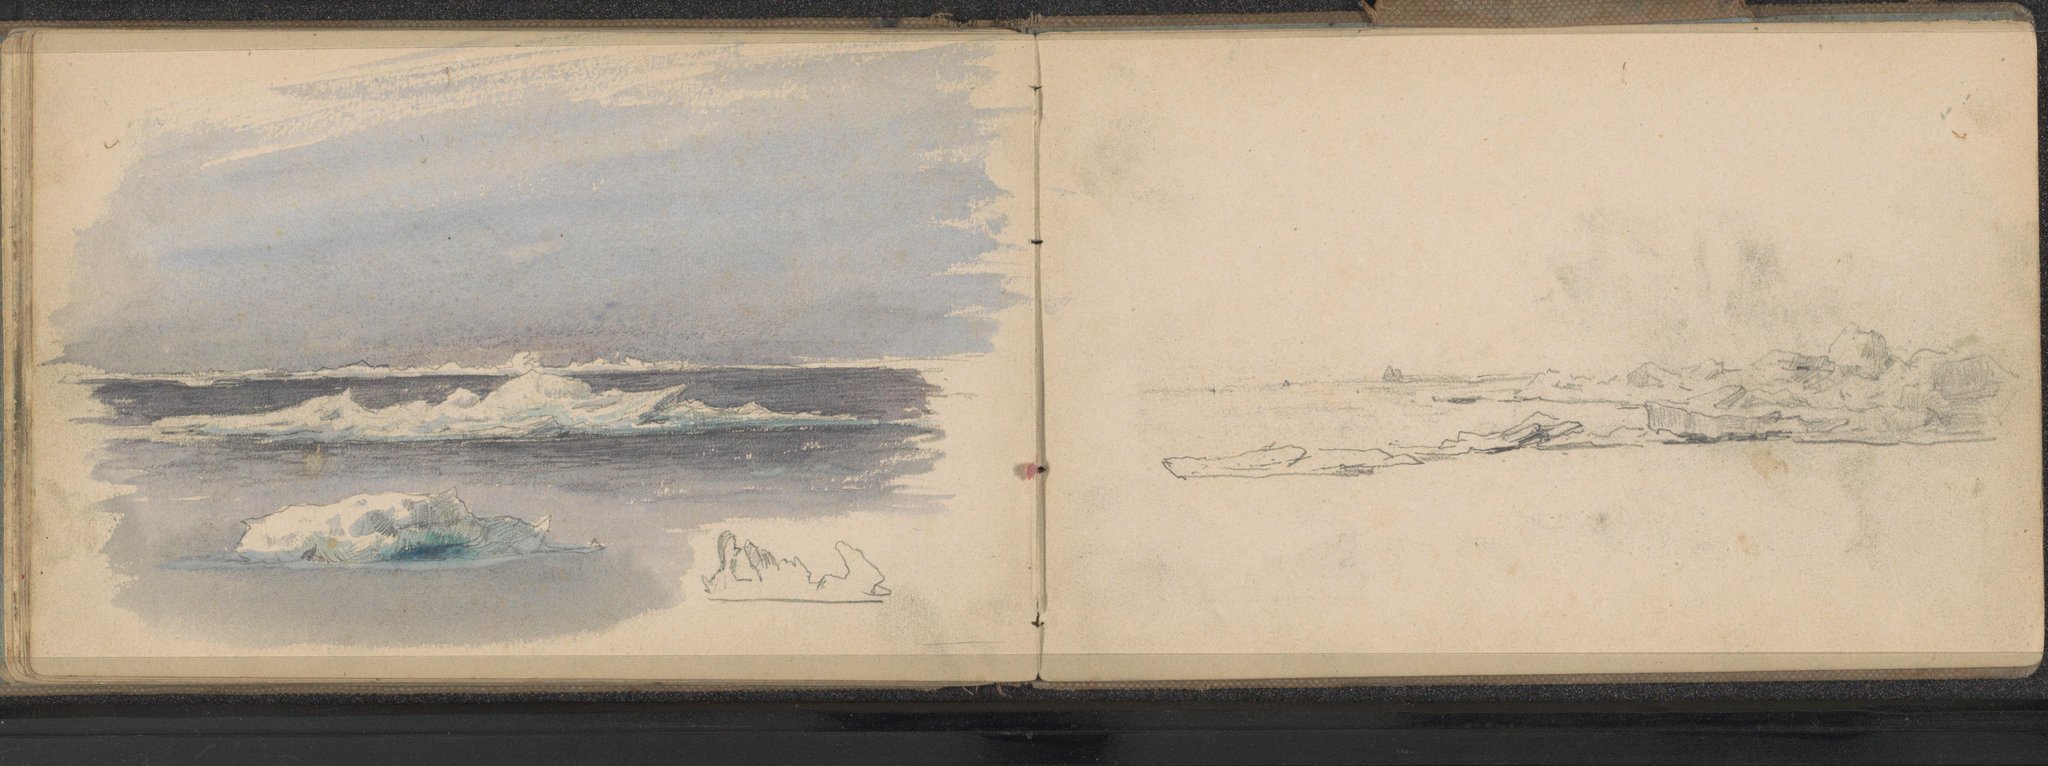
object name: sketchbook leaf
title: Gezicht op de Barentszzee met ijsbergen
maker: louis apol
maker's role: draughtsman, painter, print maker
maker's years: 1850-1936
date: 1880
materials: paper, pencil, watercolor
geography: barentsz sea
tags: iceberg, sea (seascape)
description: Blad 34 verso uit een schetsboek met 35 bladen betekend tijdens de expeditie naar Nova Zembla in 1880.